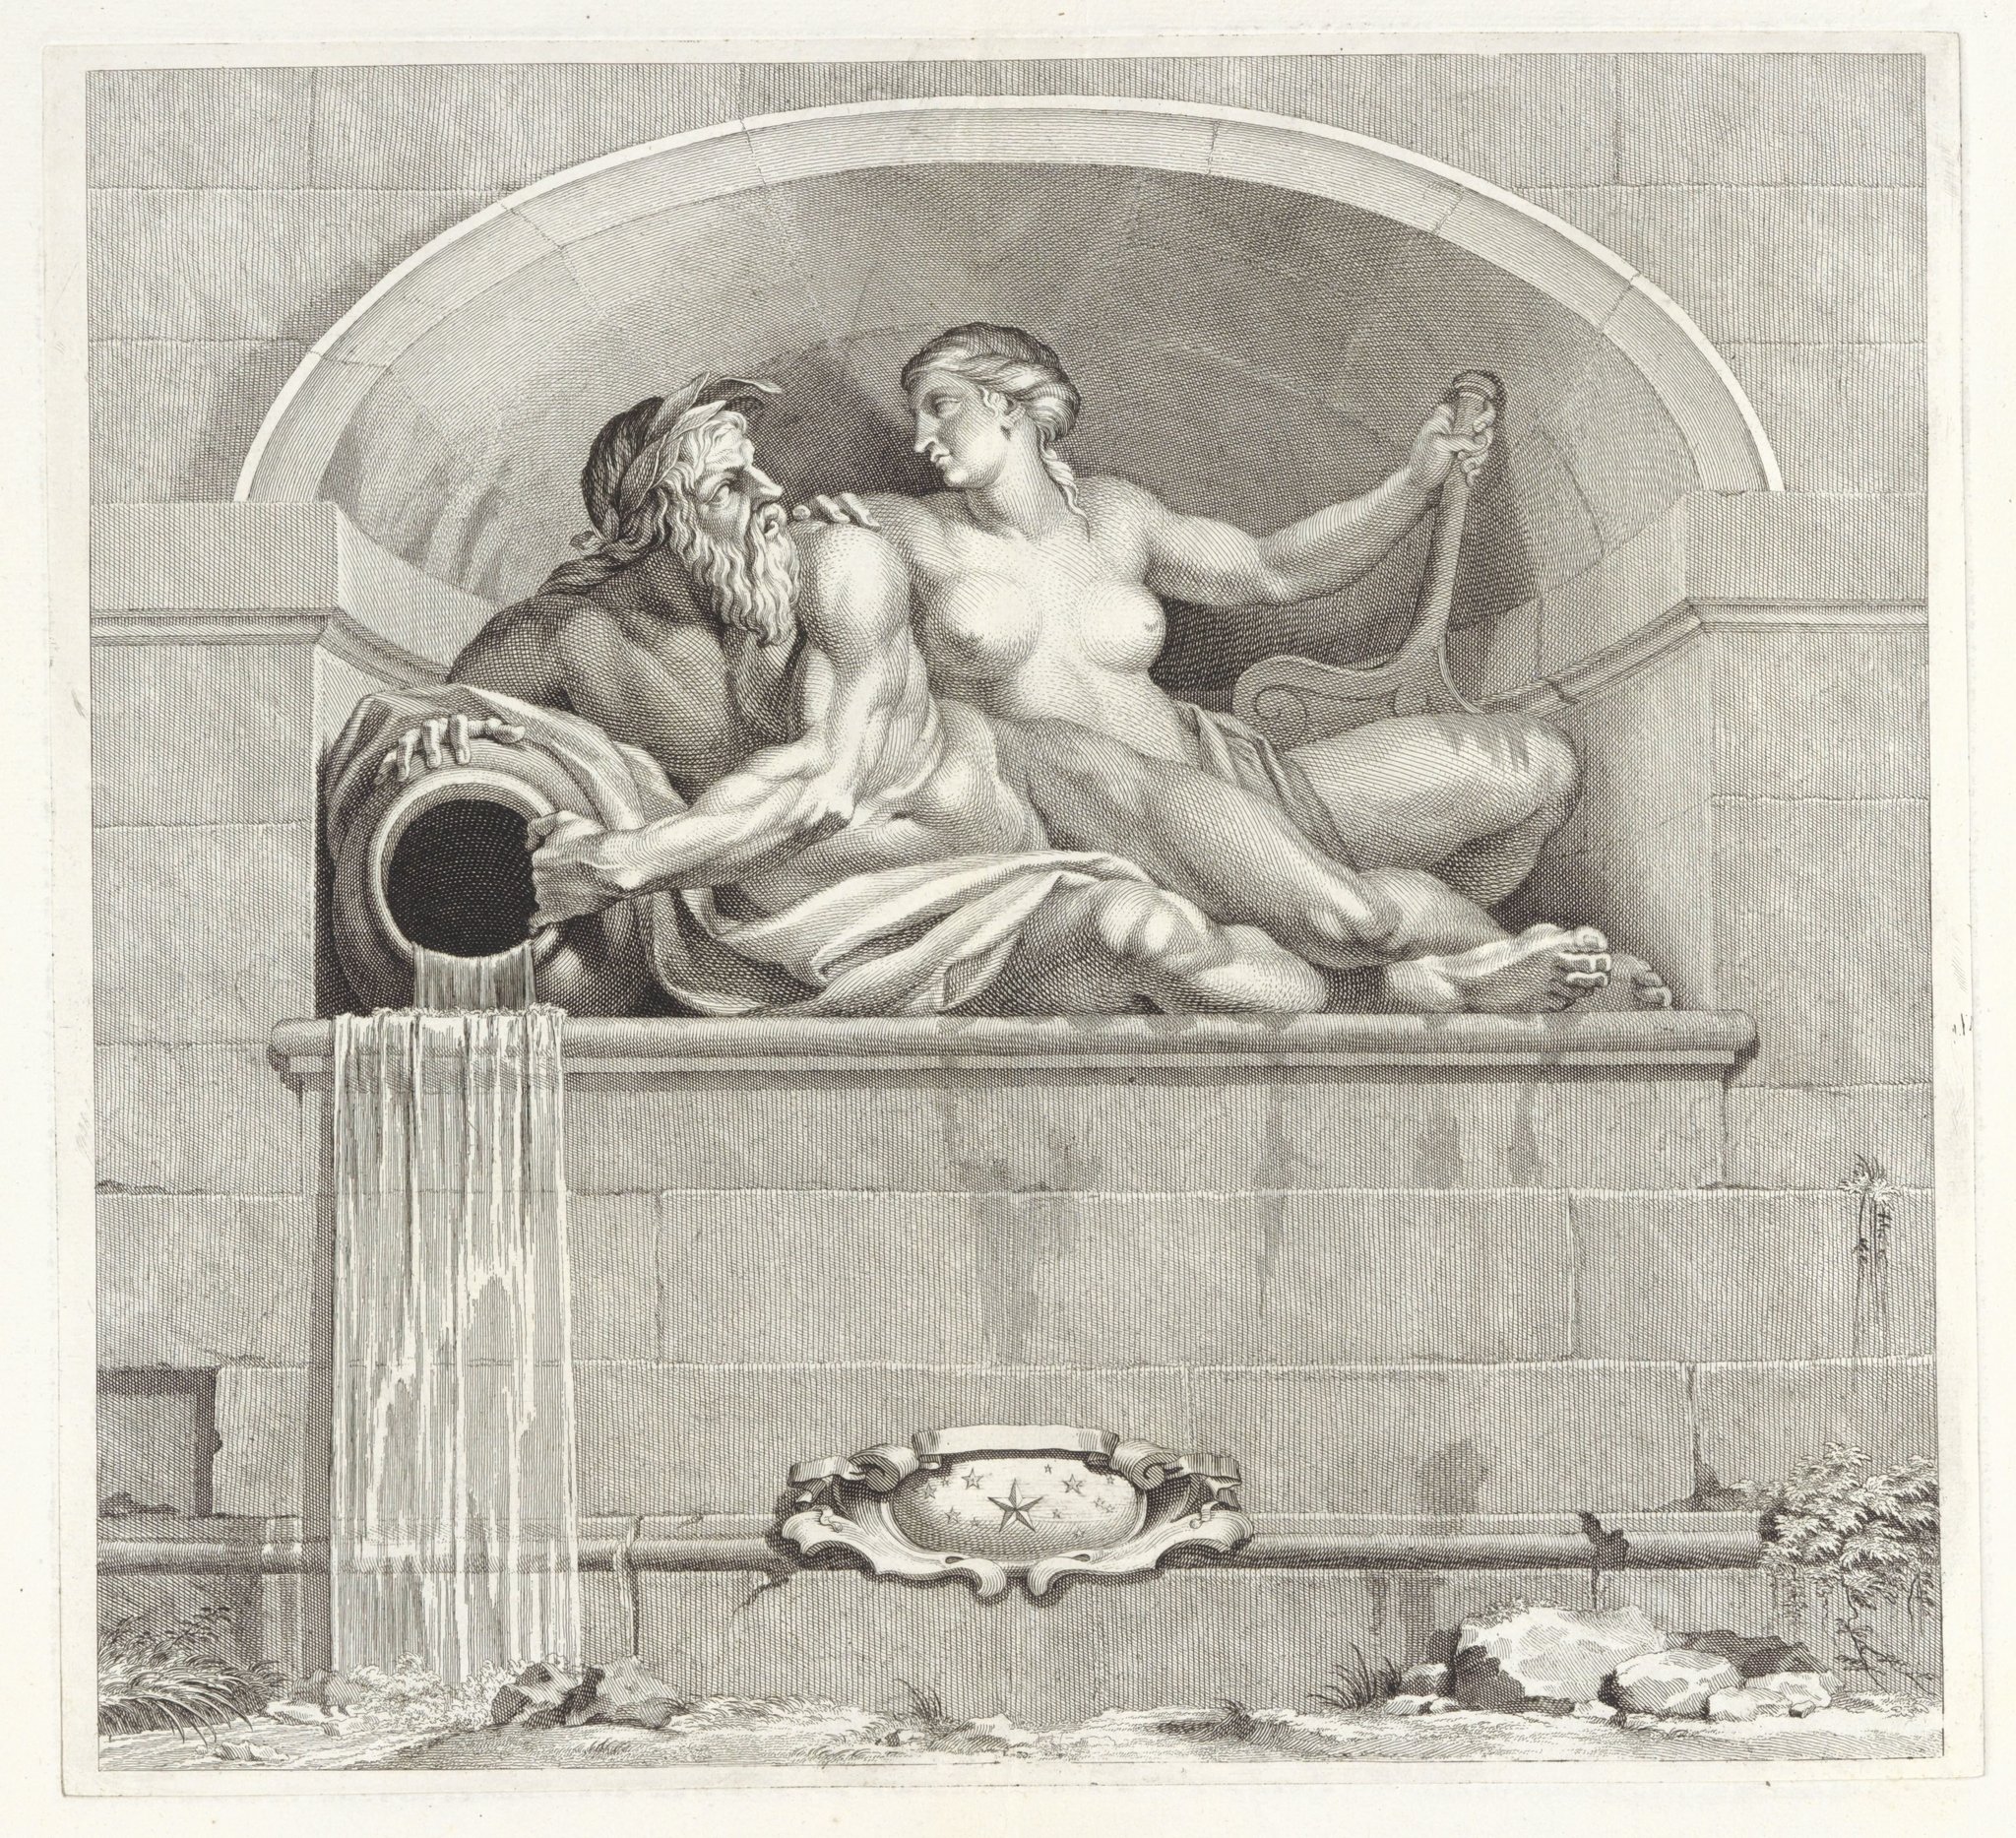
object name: print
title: Riviergod en een naiade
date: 1720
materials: paper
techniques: engraving, etching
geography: amsterdam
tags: river personified, 'fiumi' (ripa), naiads, river- and spring-nymphs; usually carrying an urn; 'naiadi, ninfe de' fiumi' (ripa)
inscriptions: collector's mark: Lugt 2228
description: Nis met een riviergod, die wordt vergezeld door een Naiade, een waternimf. Midden onder een ornamenteel cartouche met het vignet van Bernard Picart: een grote ster te midden van andere sterren. Naar het door Lesueur geschilderde grisaille in een nis bij de toegang tot de trap in het Hôtel Lambert. Prent maakt deel uit van een serie prenten naar de schilderijen in het Hôtel Lambert te Parijs.